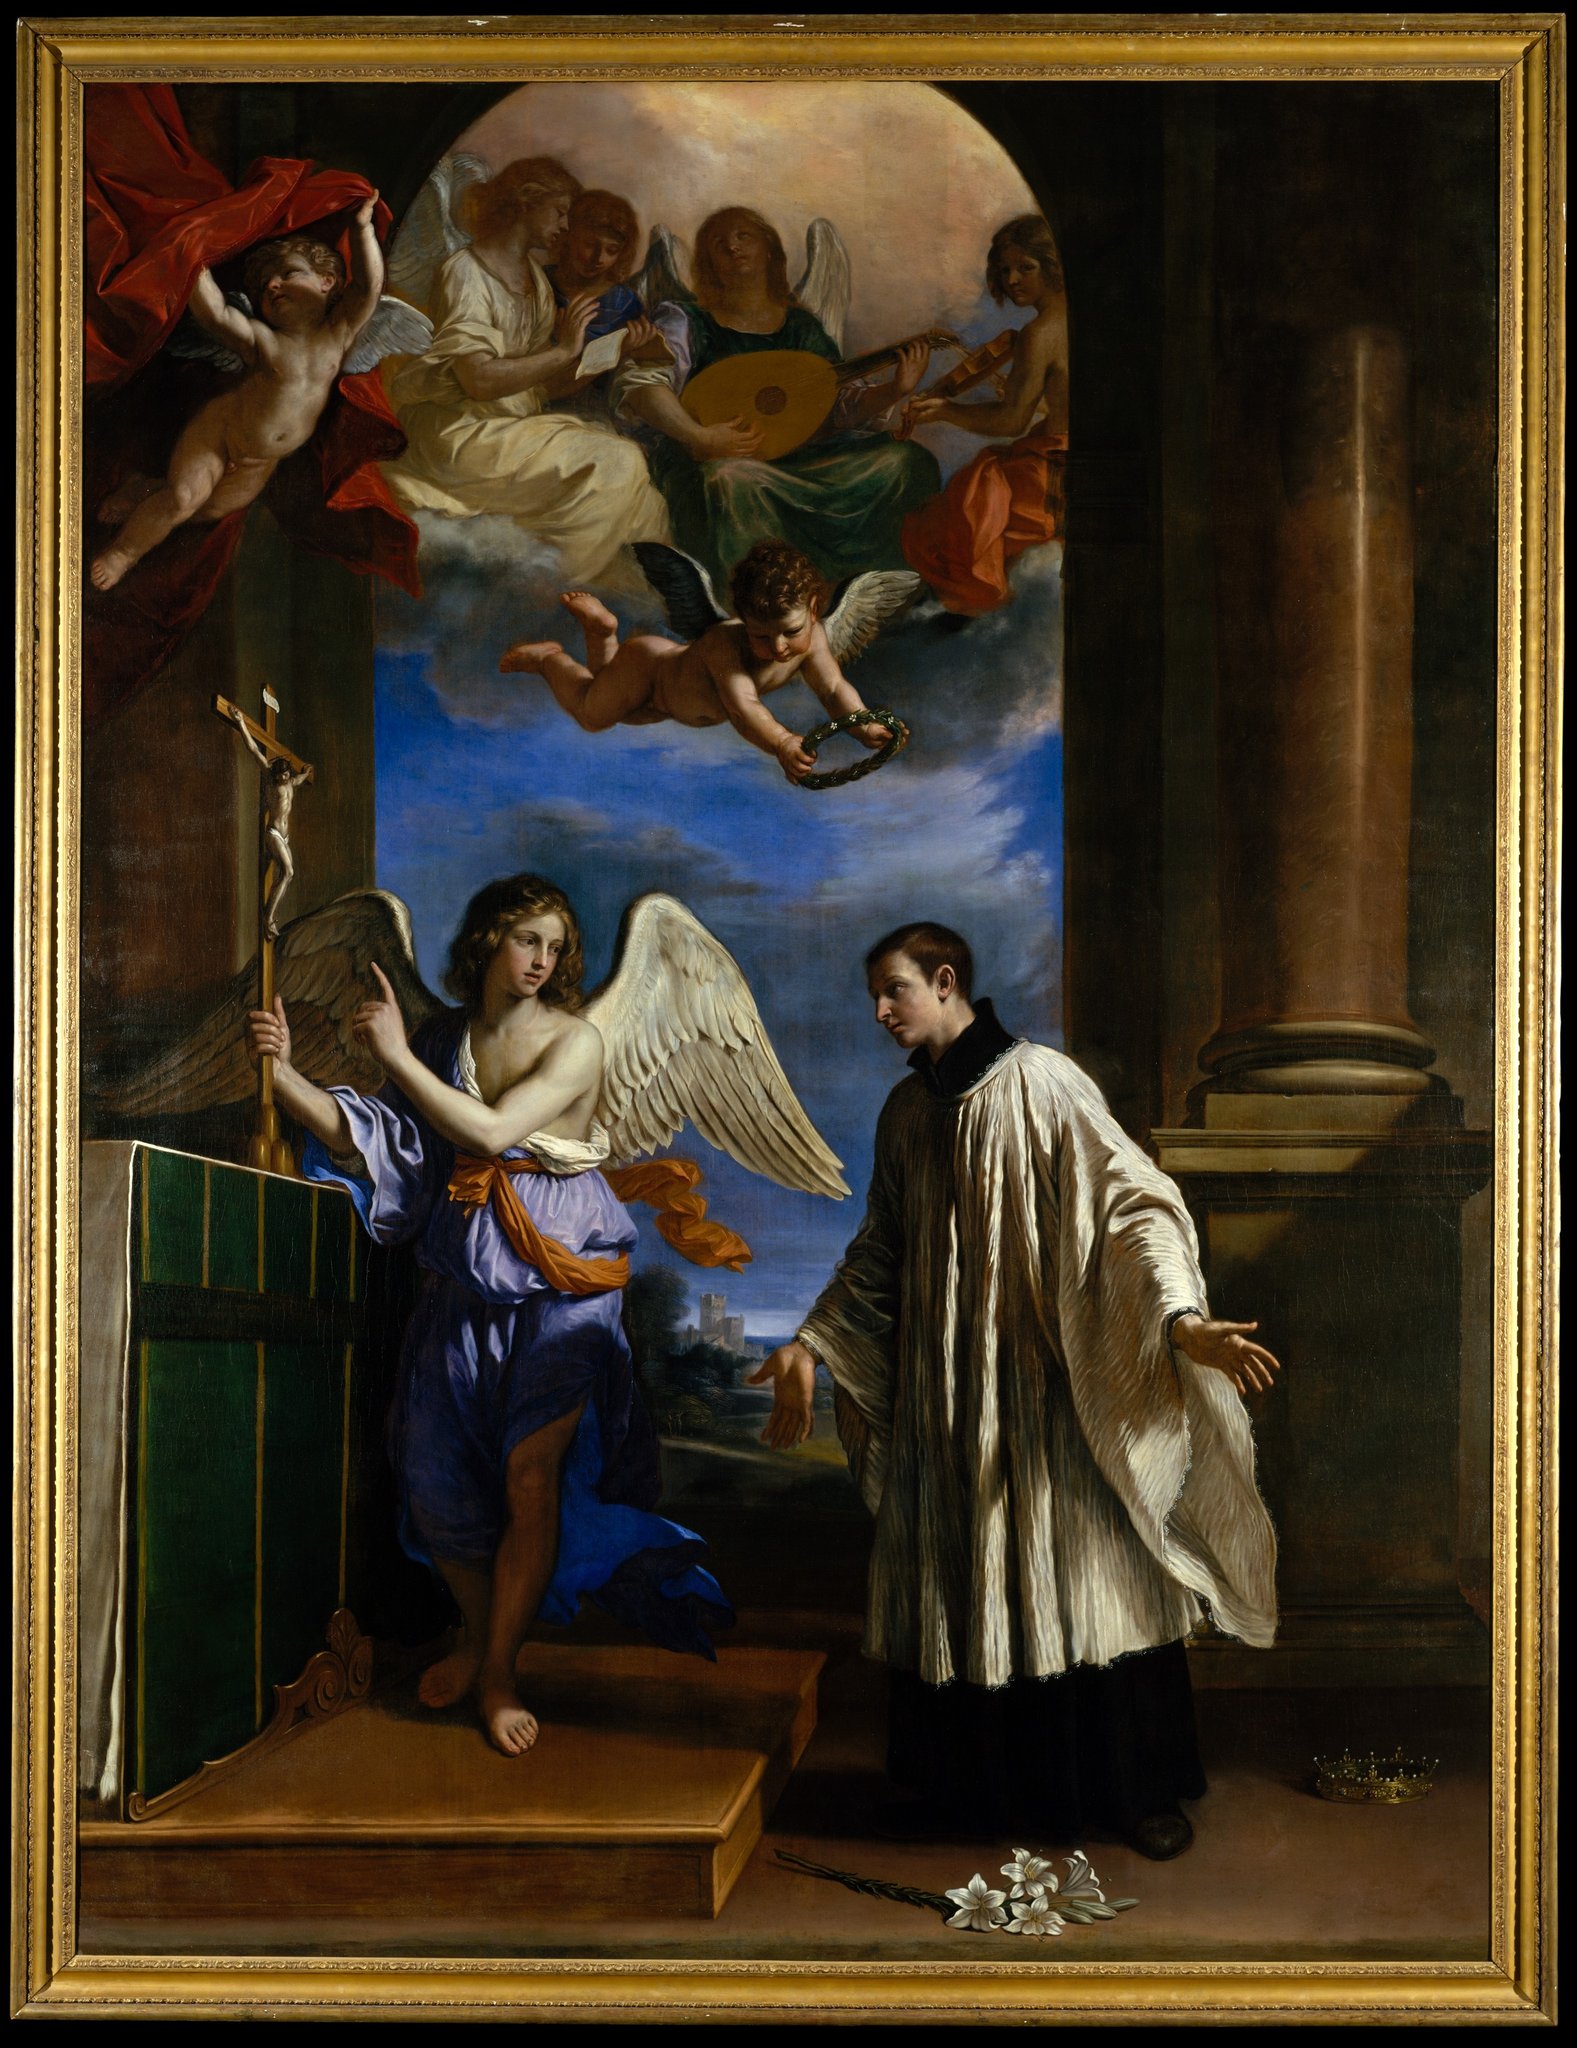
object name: painting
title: The Vocation of Saint Aloysius (Luigi) Gonzaga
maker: guercino (giovanni francesco barbieri)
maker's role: artist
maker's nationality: italian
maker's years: 1591-1666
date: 1650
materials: canvas, oil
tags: altars,men,angels,cross,crucifixion,saints